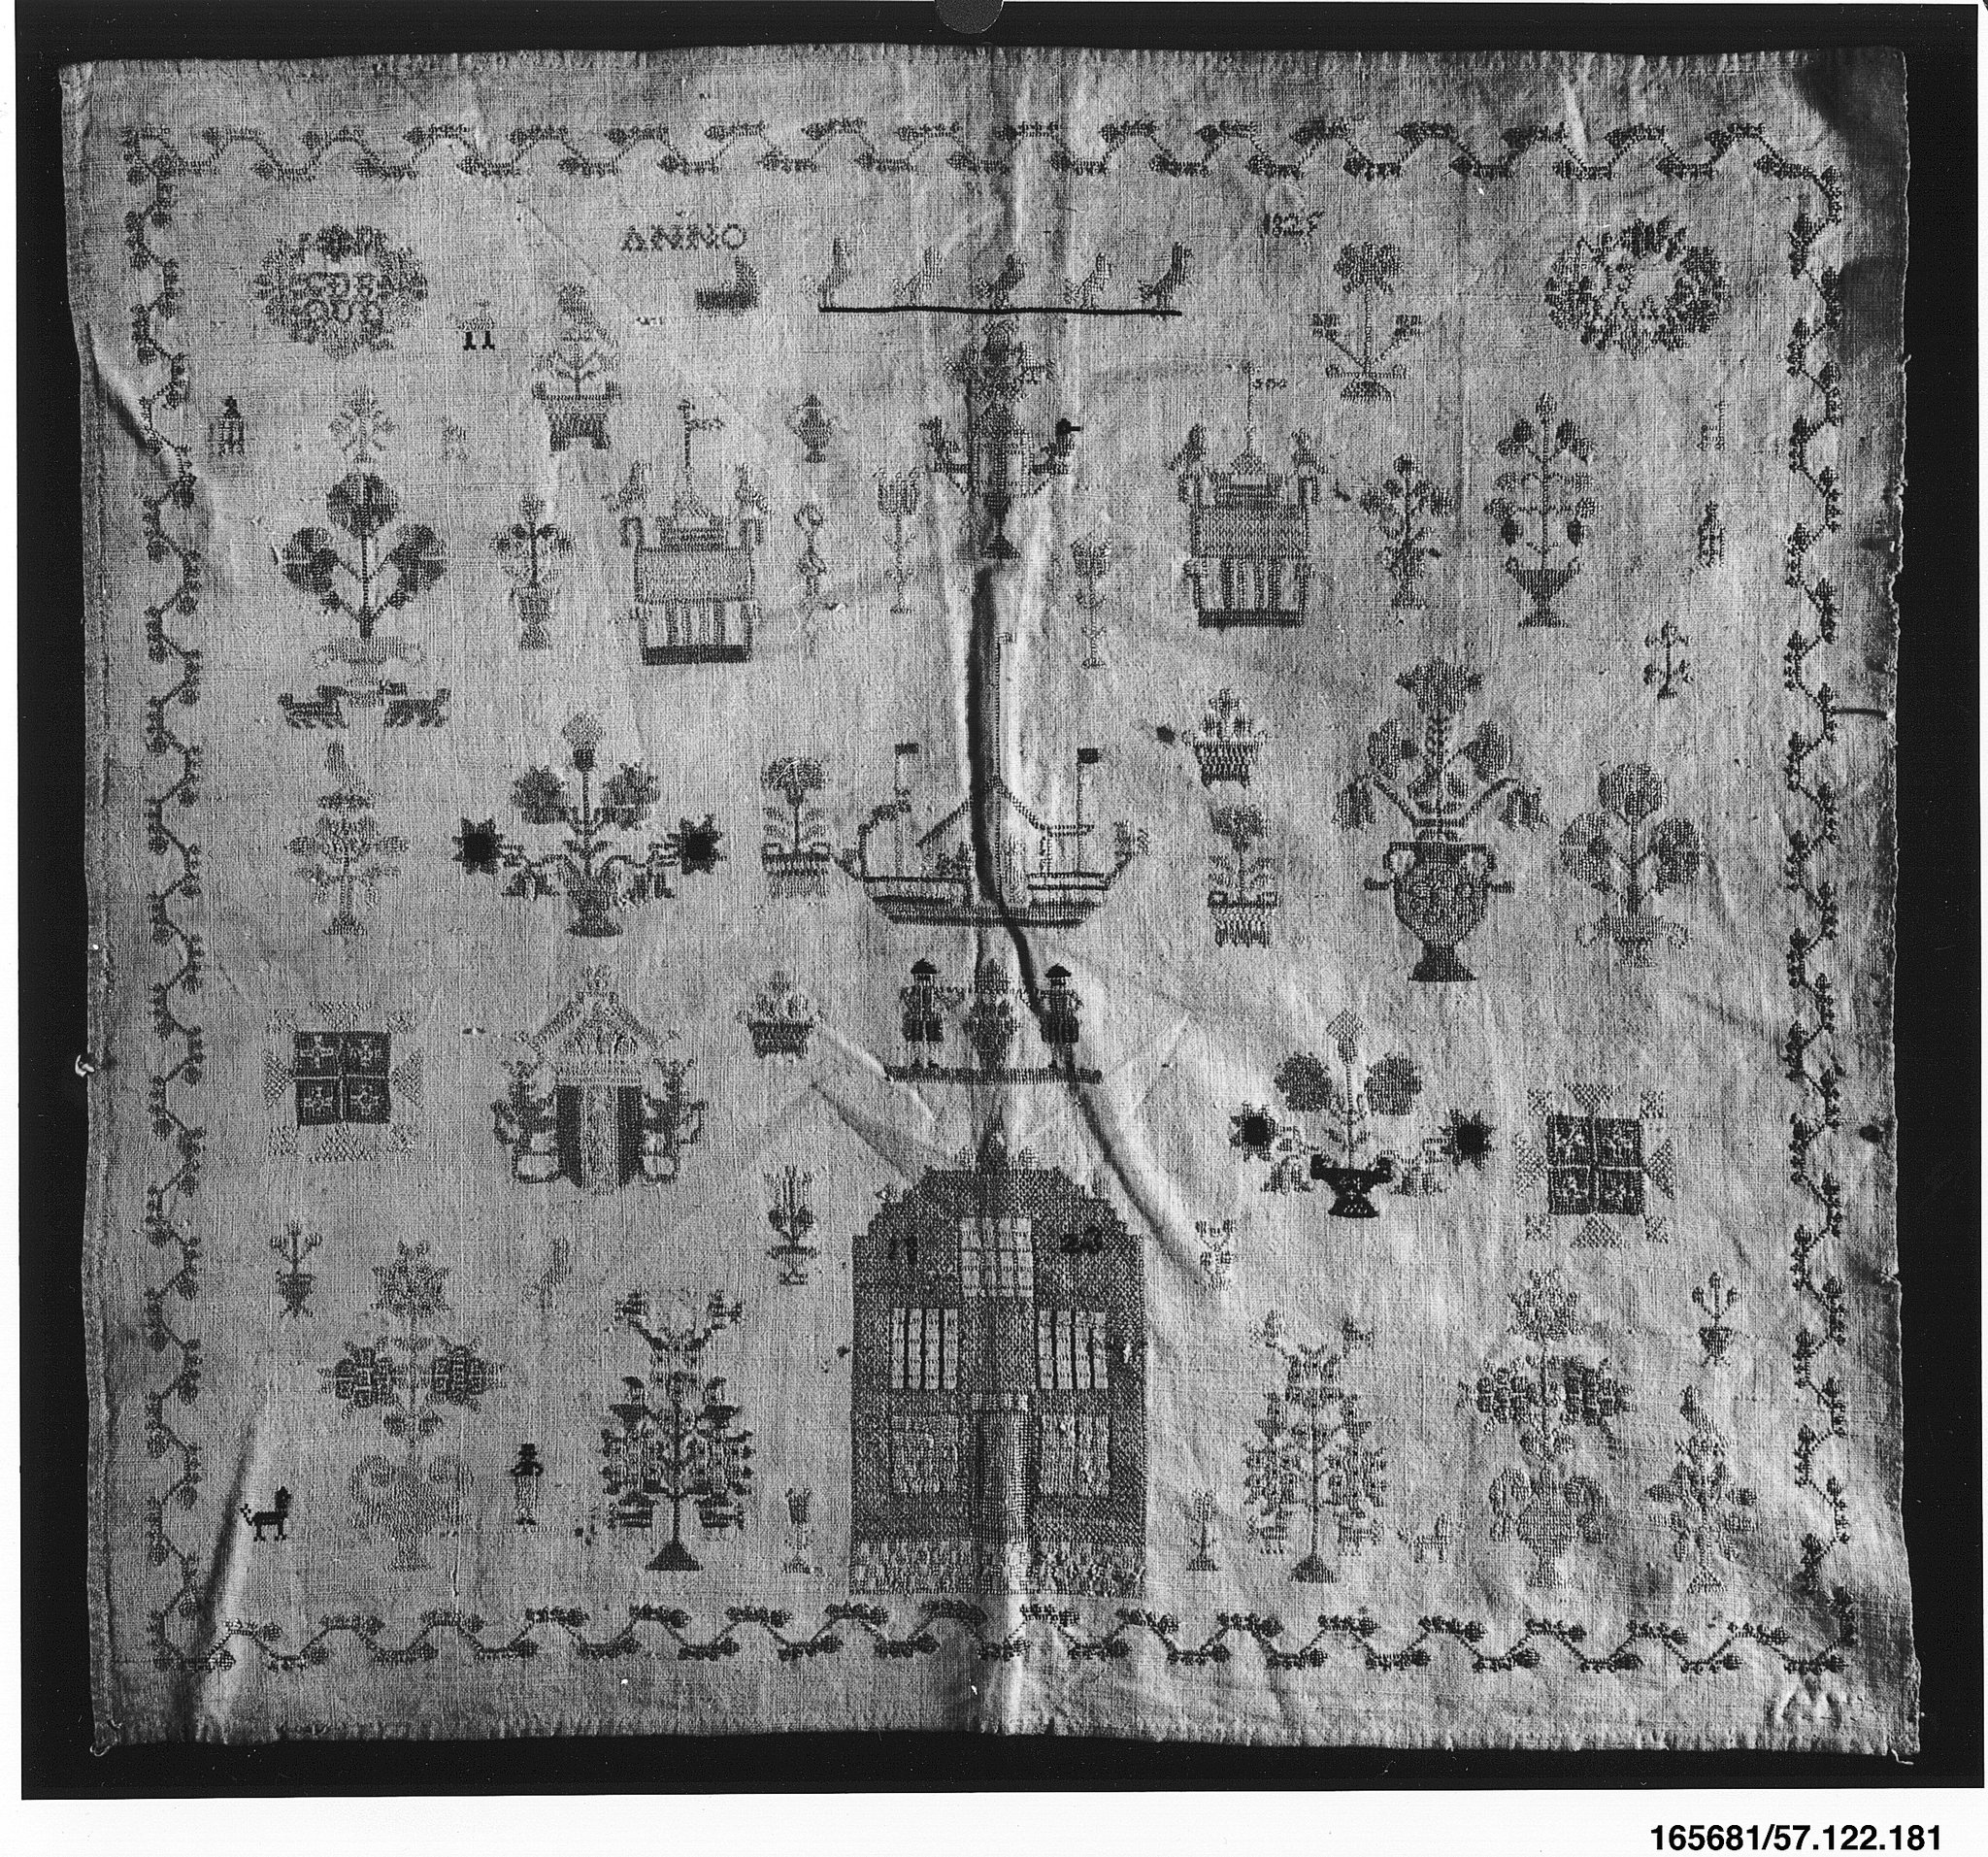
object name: sampler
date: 1823-1825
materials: cotton, silk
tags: flowers,leaves,boats